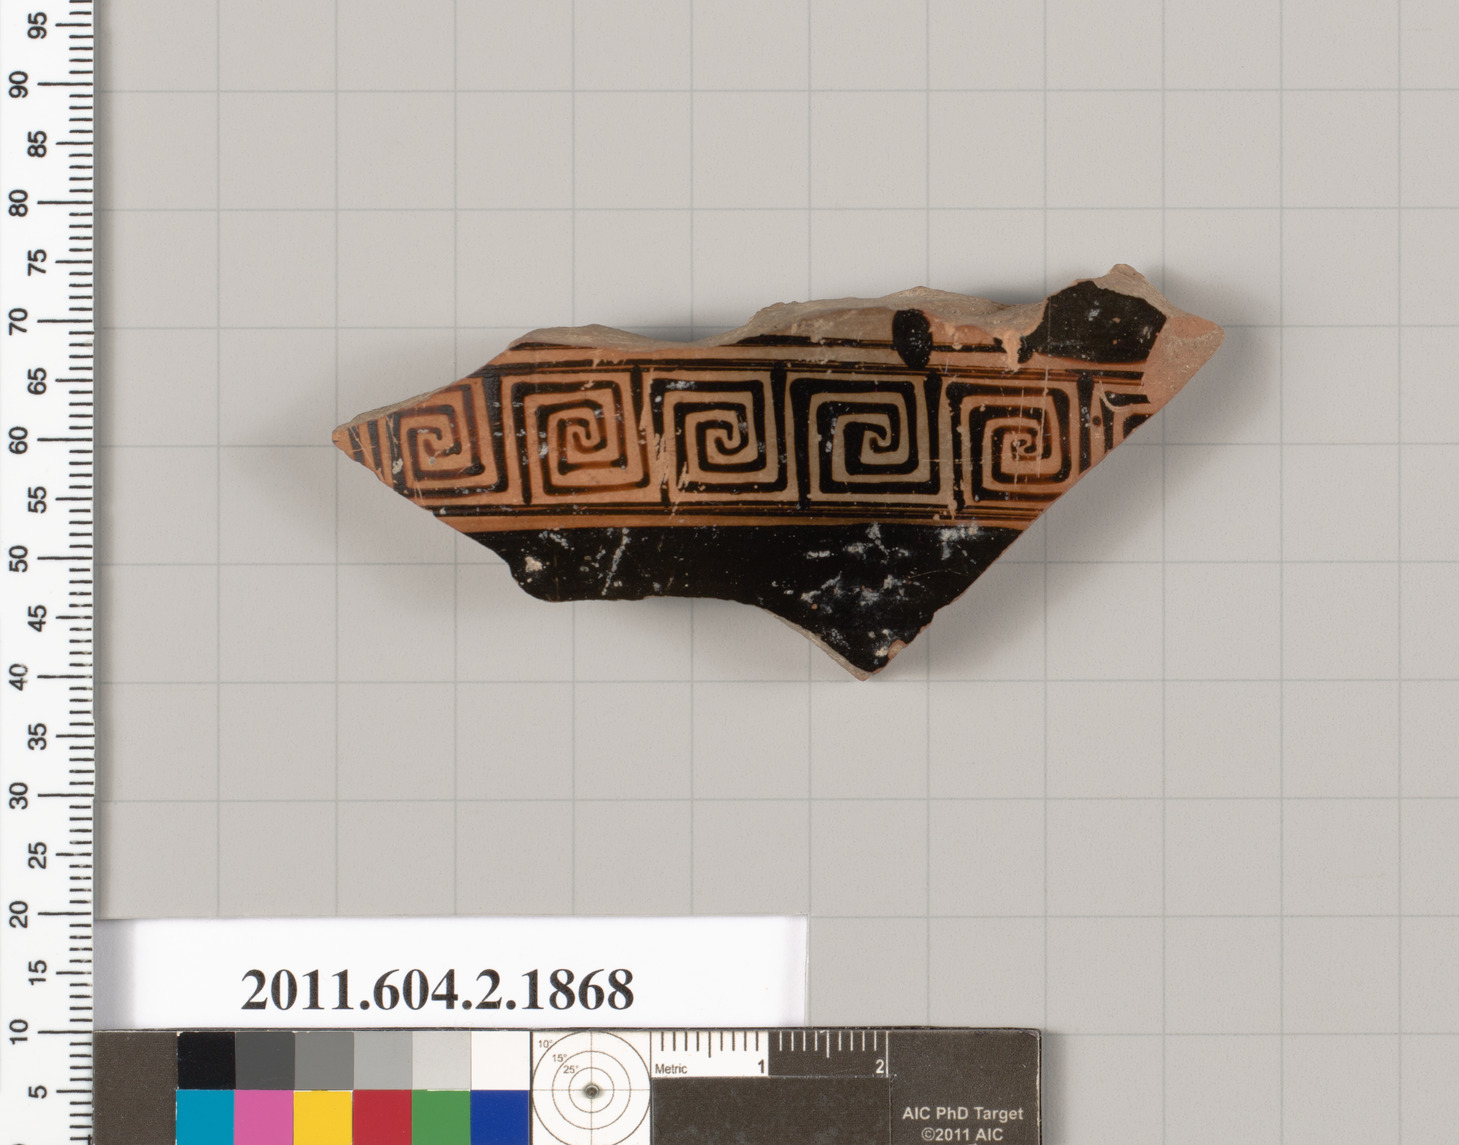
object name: skyphos fragment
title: Terracotta fragment of a skyphos (deep drinking cup)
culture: greek, attic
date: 460-450 BCE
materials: terracotta